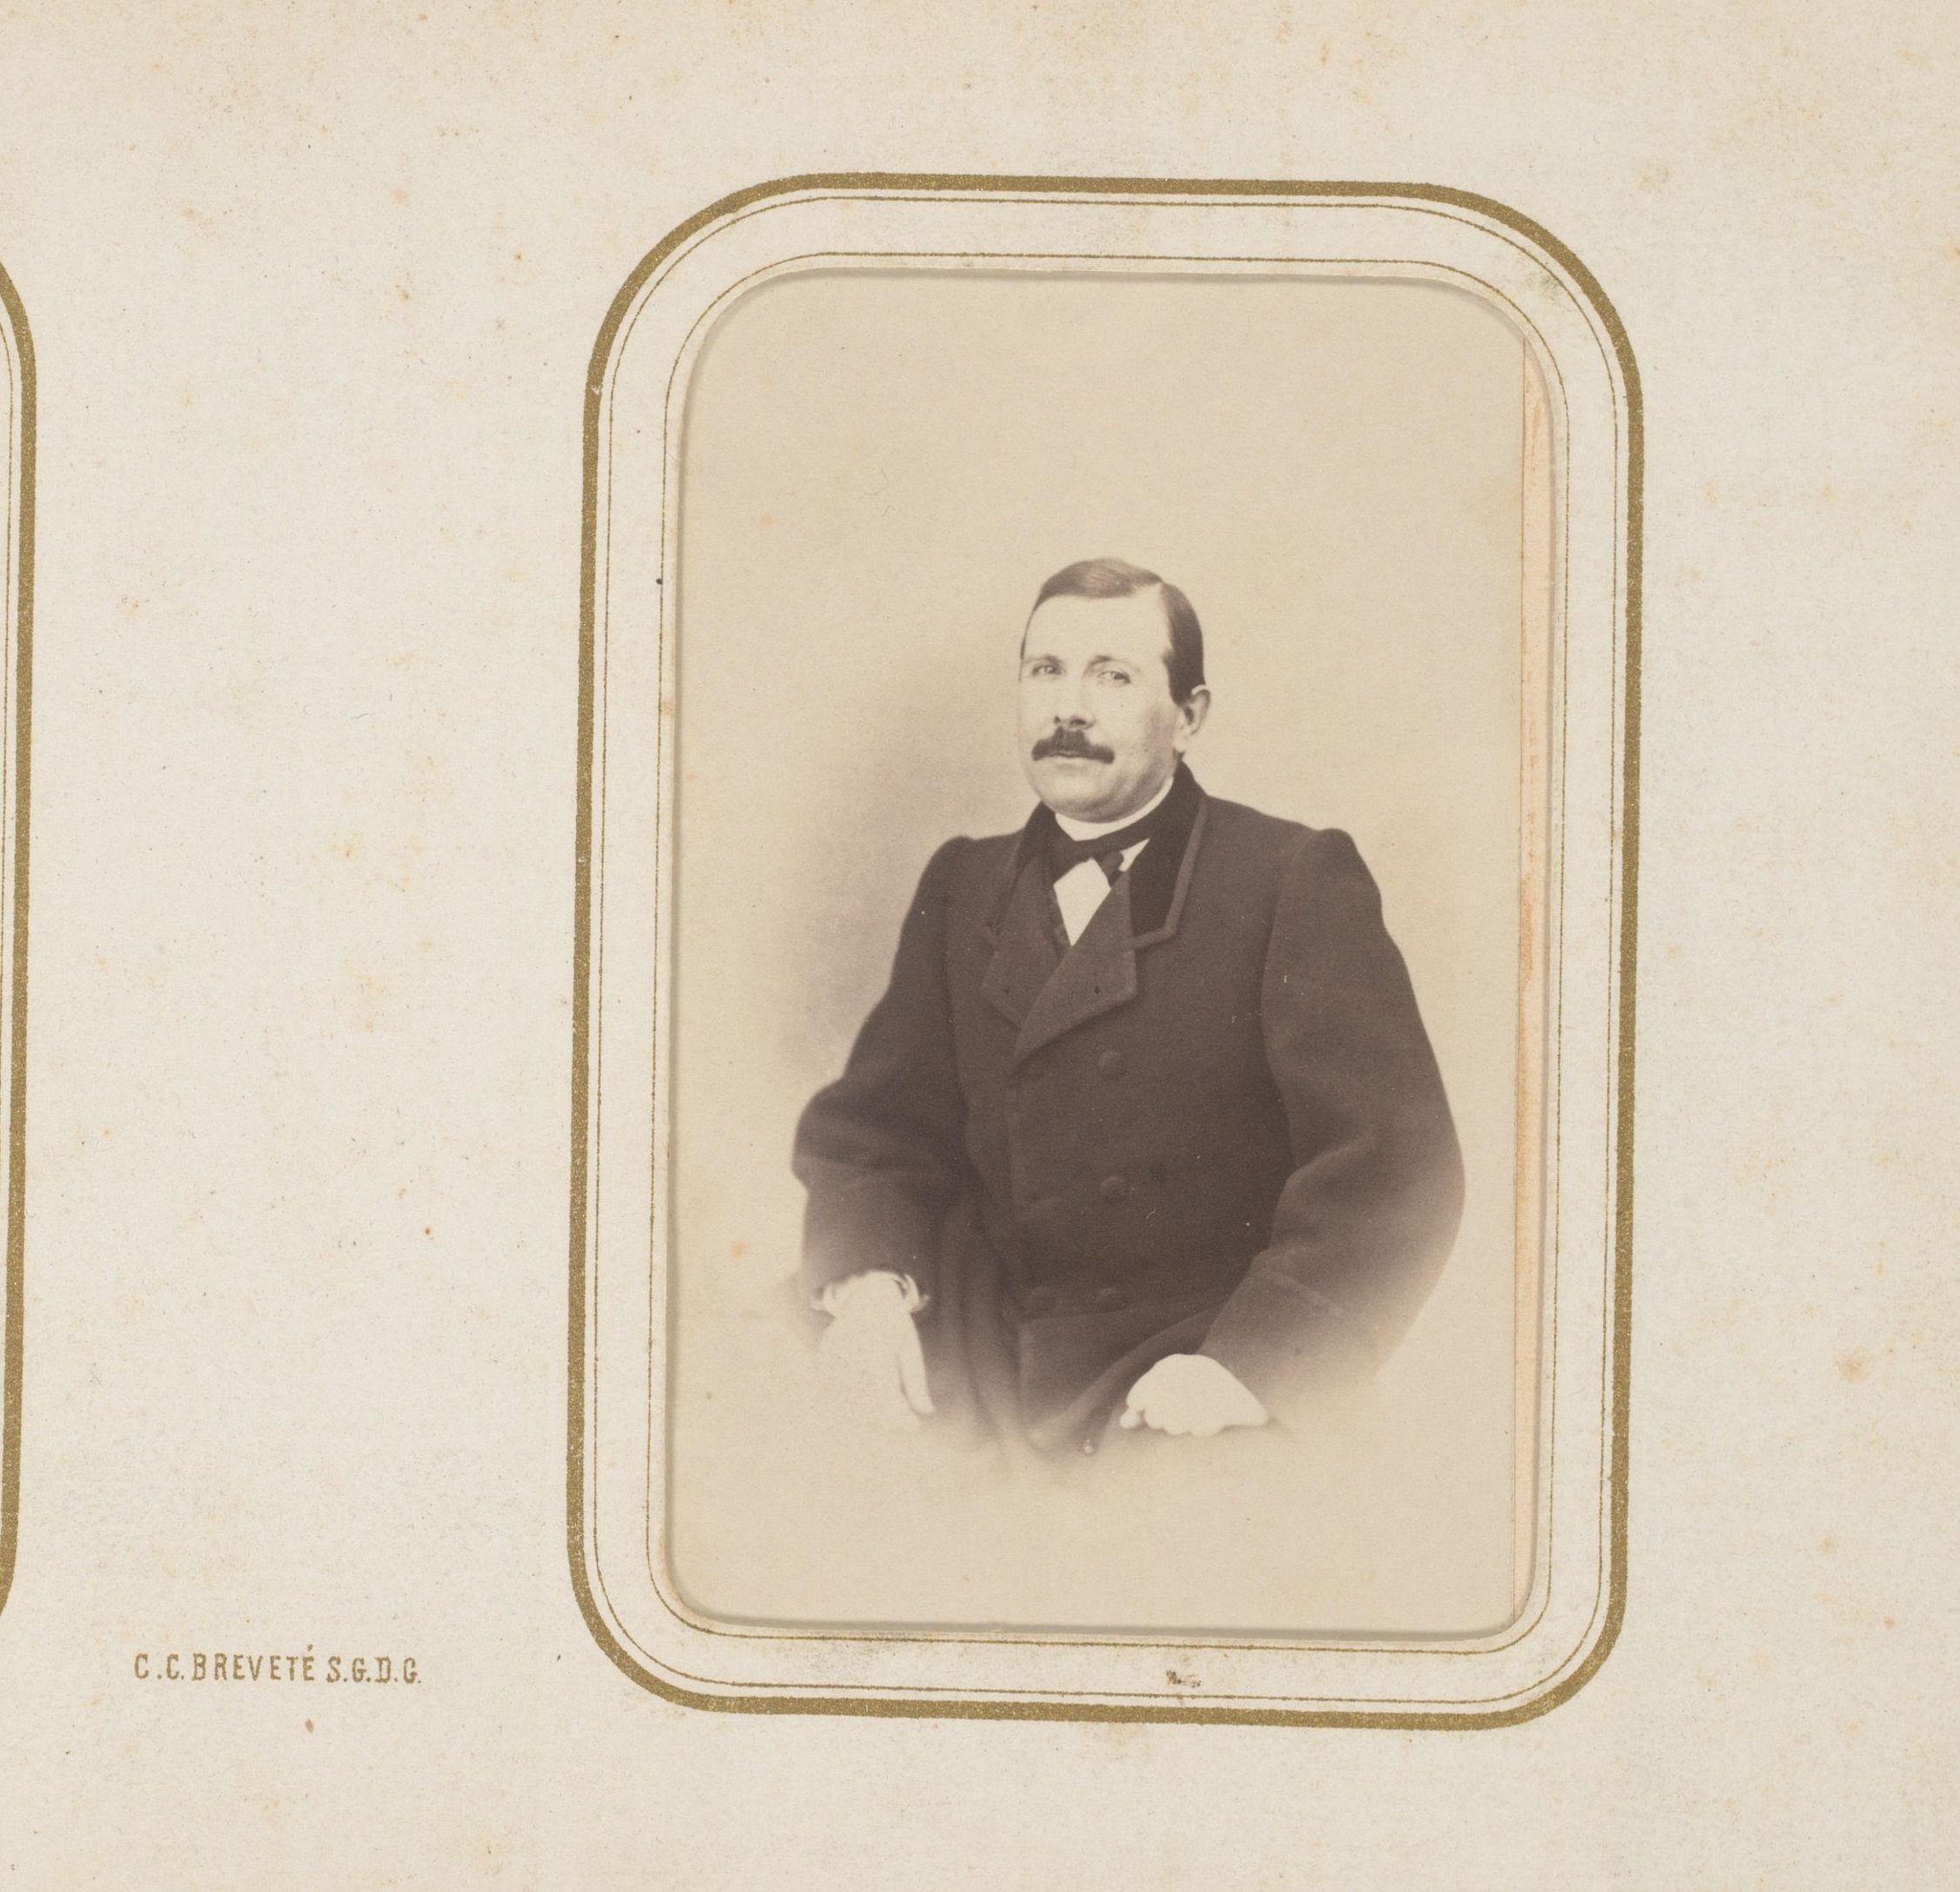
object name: album leaf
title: Portret van een man met een snor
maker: Anonymous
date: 1860-1900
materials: cardboard, photographic support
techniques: albumen print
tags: moustache, adult man, historical persons